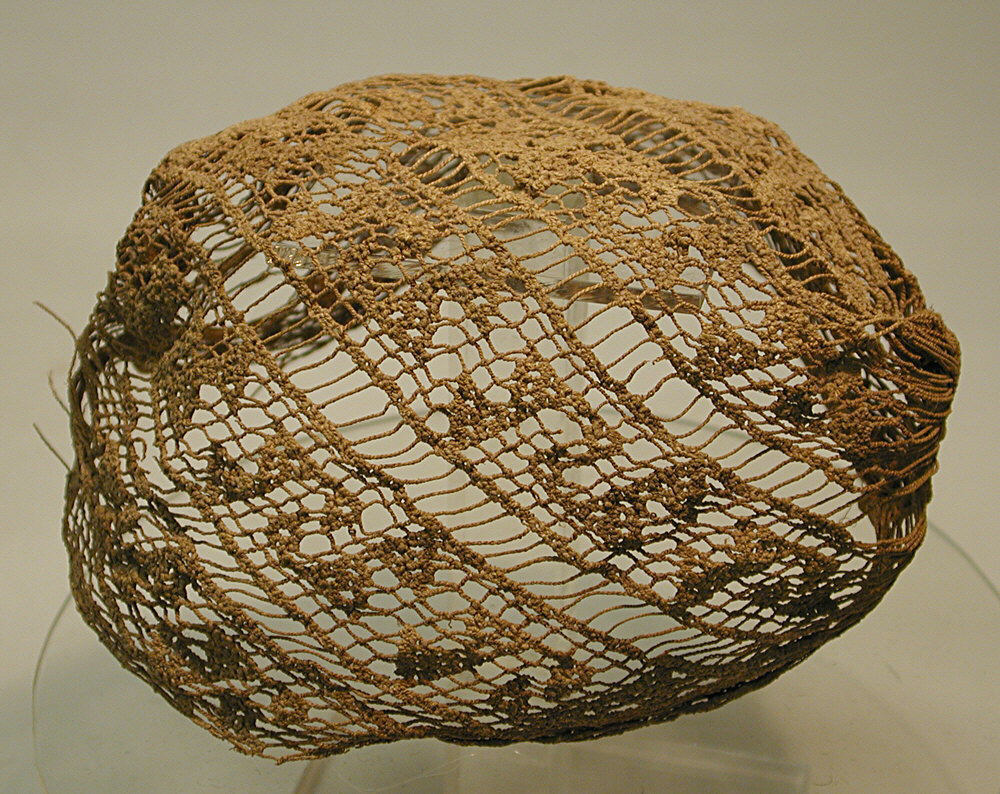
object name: hat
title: Openweave Cap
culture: peruvian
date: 1301-1533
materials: cotton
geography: peru